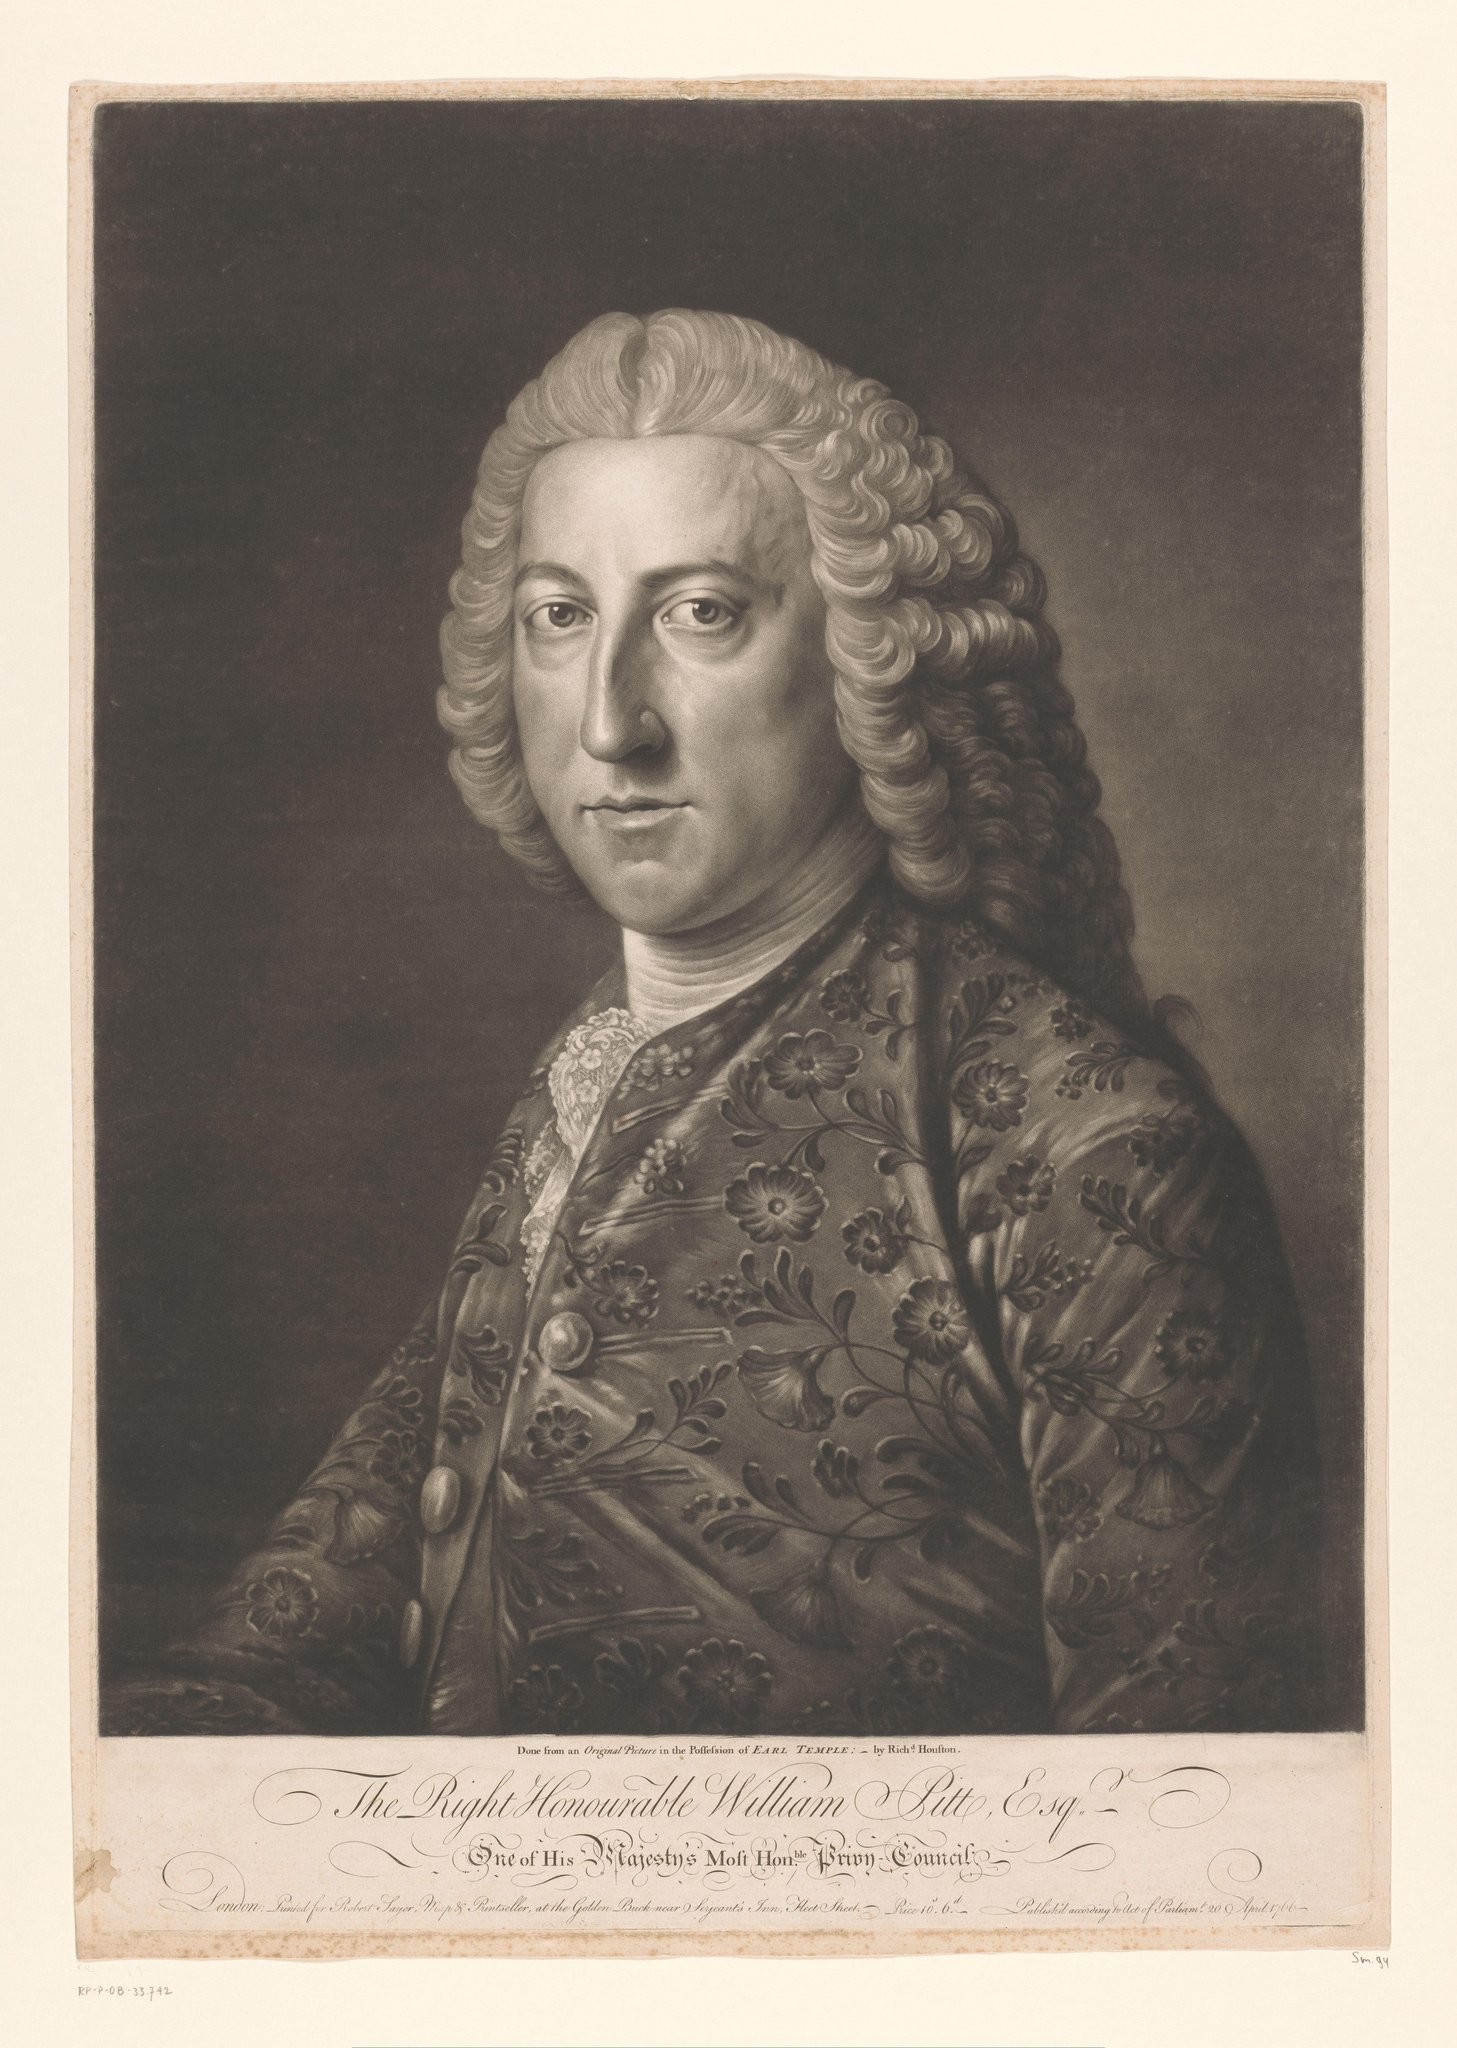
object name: print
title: Portret van William Pitt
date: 1766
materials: paper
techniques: mezzotint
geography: london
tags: london, earl, politician, william pitt (i), historical persons, politician, e.g. party leader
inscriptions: collector's mark: Lugt 240